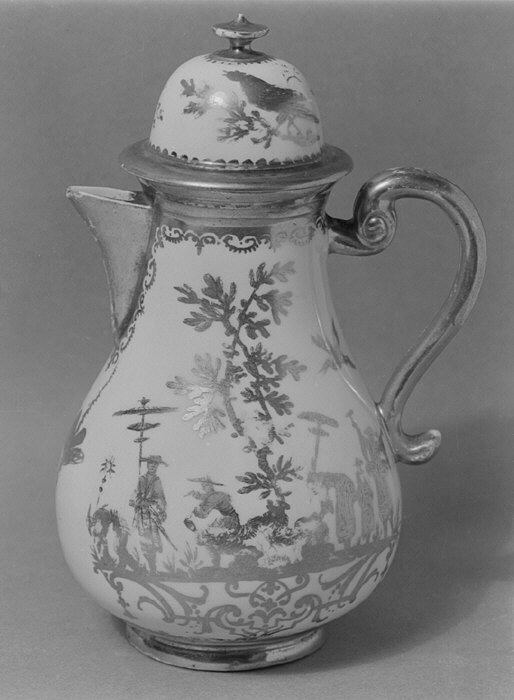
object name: coffeepot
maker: meissen manufactory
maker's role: manufactory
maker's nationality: german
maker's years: 1710-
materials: hard paste porcelain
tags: men